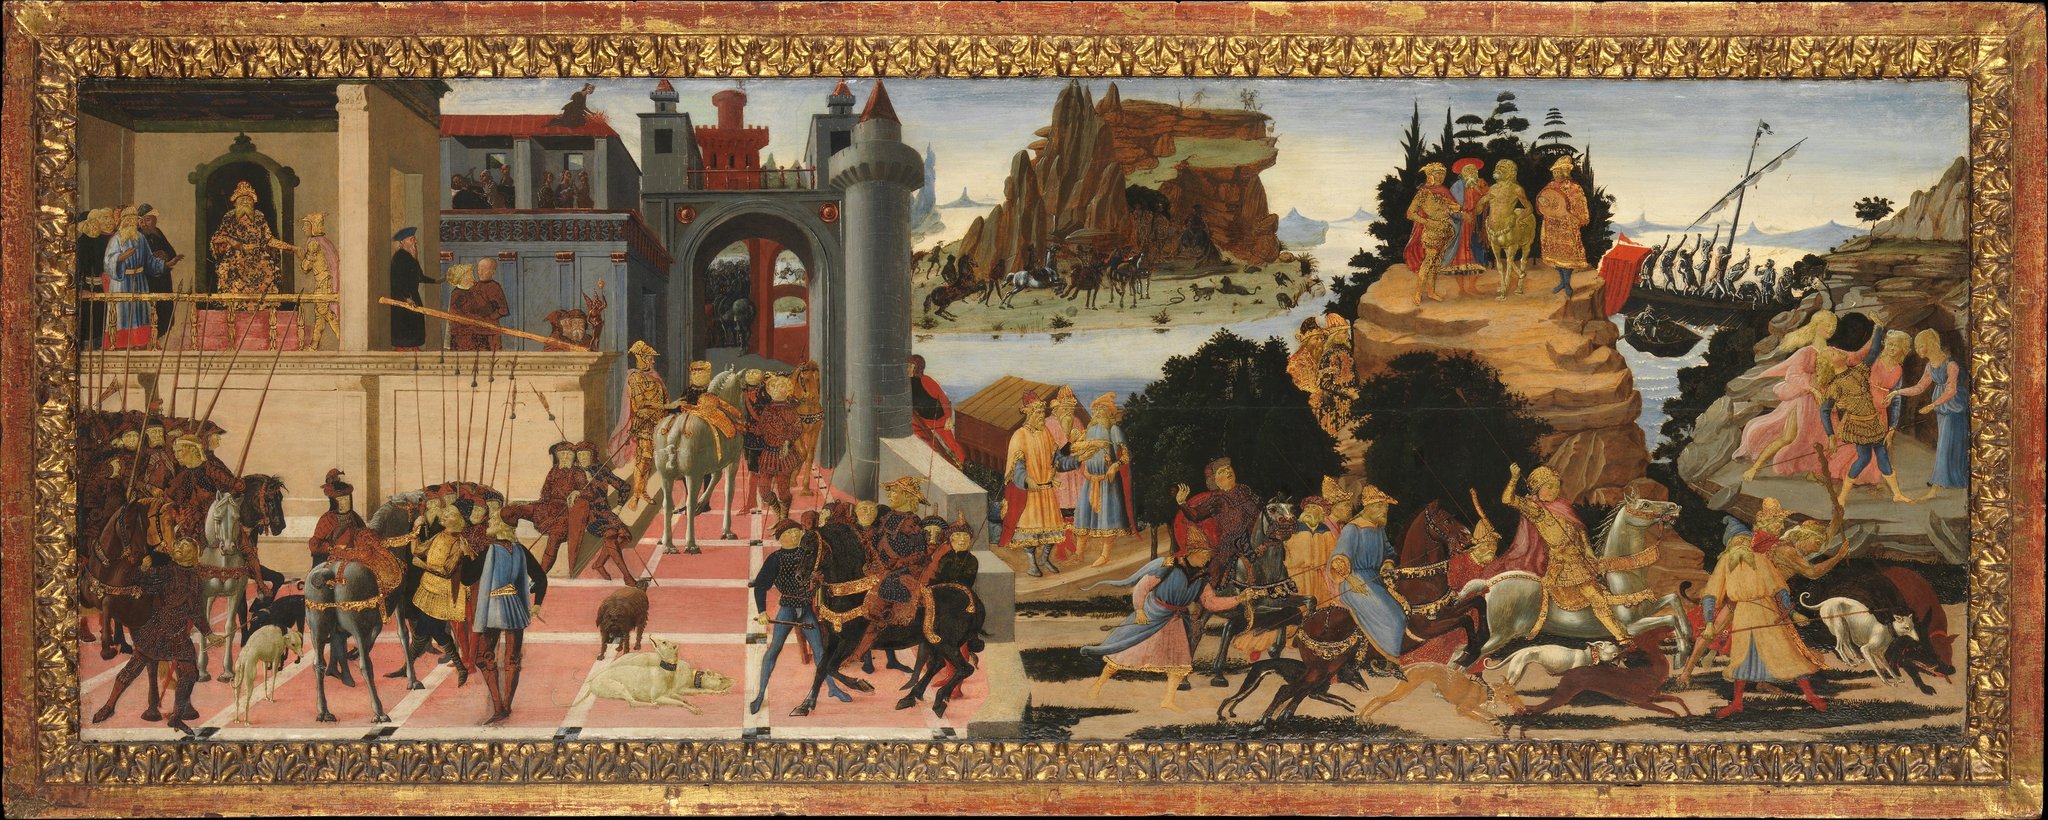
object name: painting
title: Scenes from the Story of the Argonauts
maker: jacopo di arcangelo (called jacopo del sellaio)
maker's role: artist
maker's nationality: italian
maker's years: 1441-1493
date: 1465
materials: gilt, paint, wood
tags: soldiers,argonauts,hercules,centaurs,dogs,horses,boats